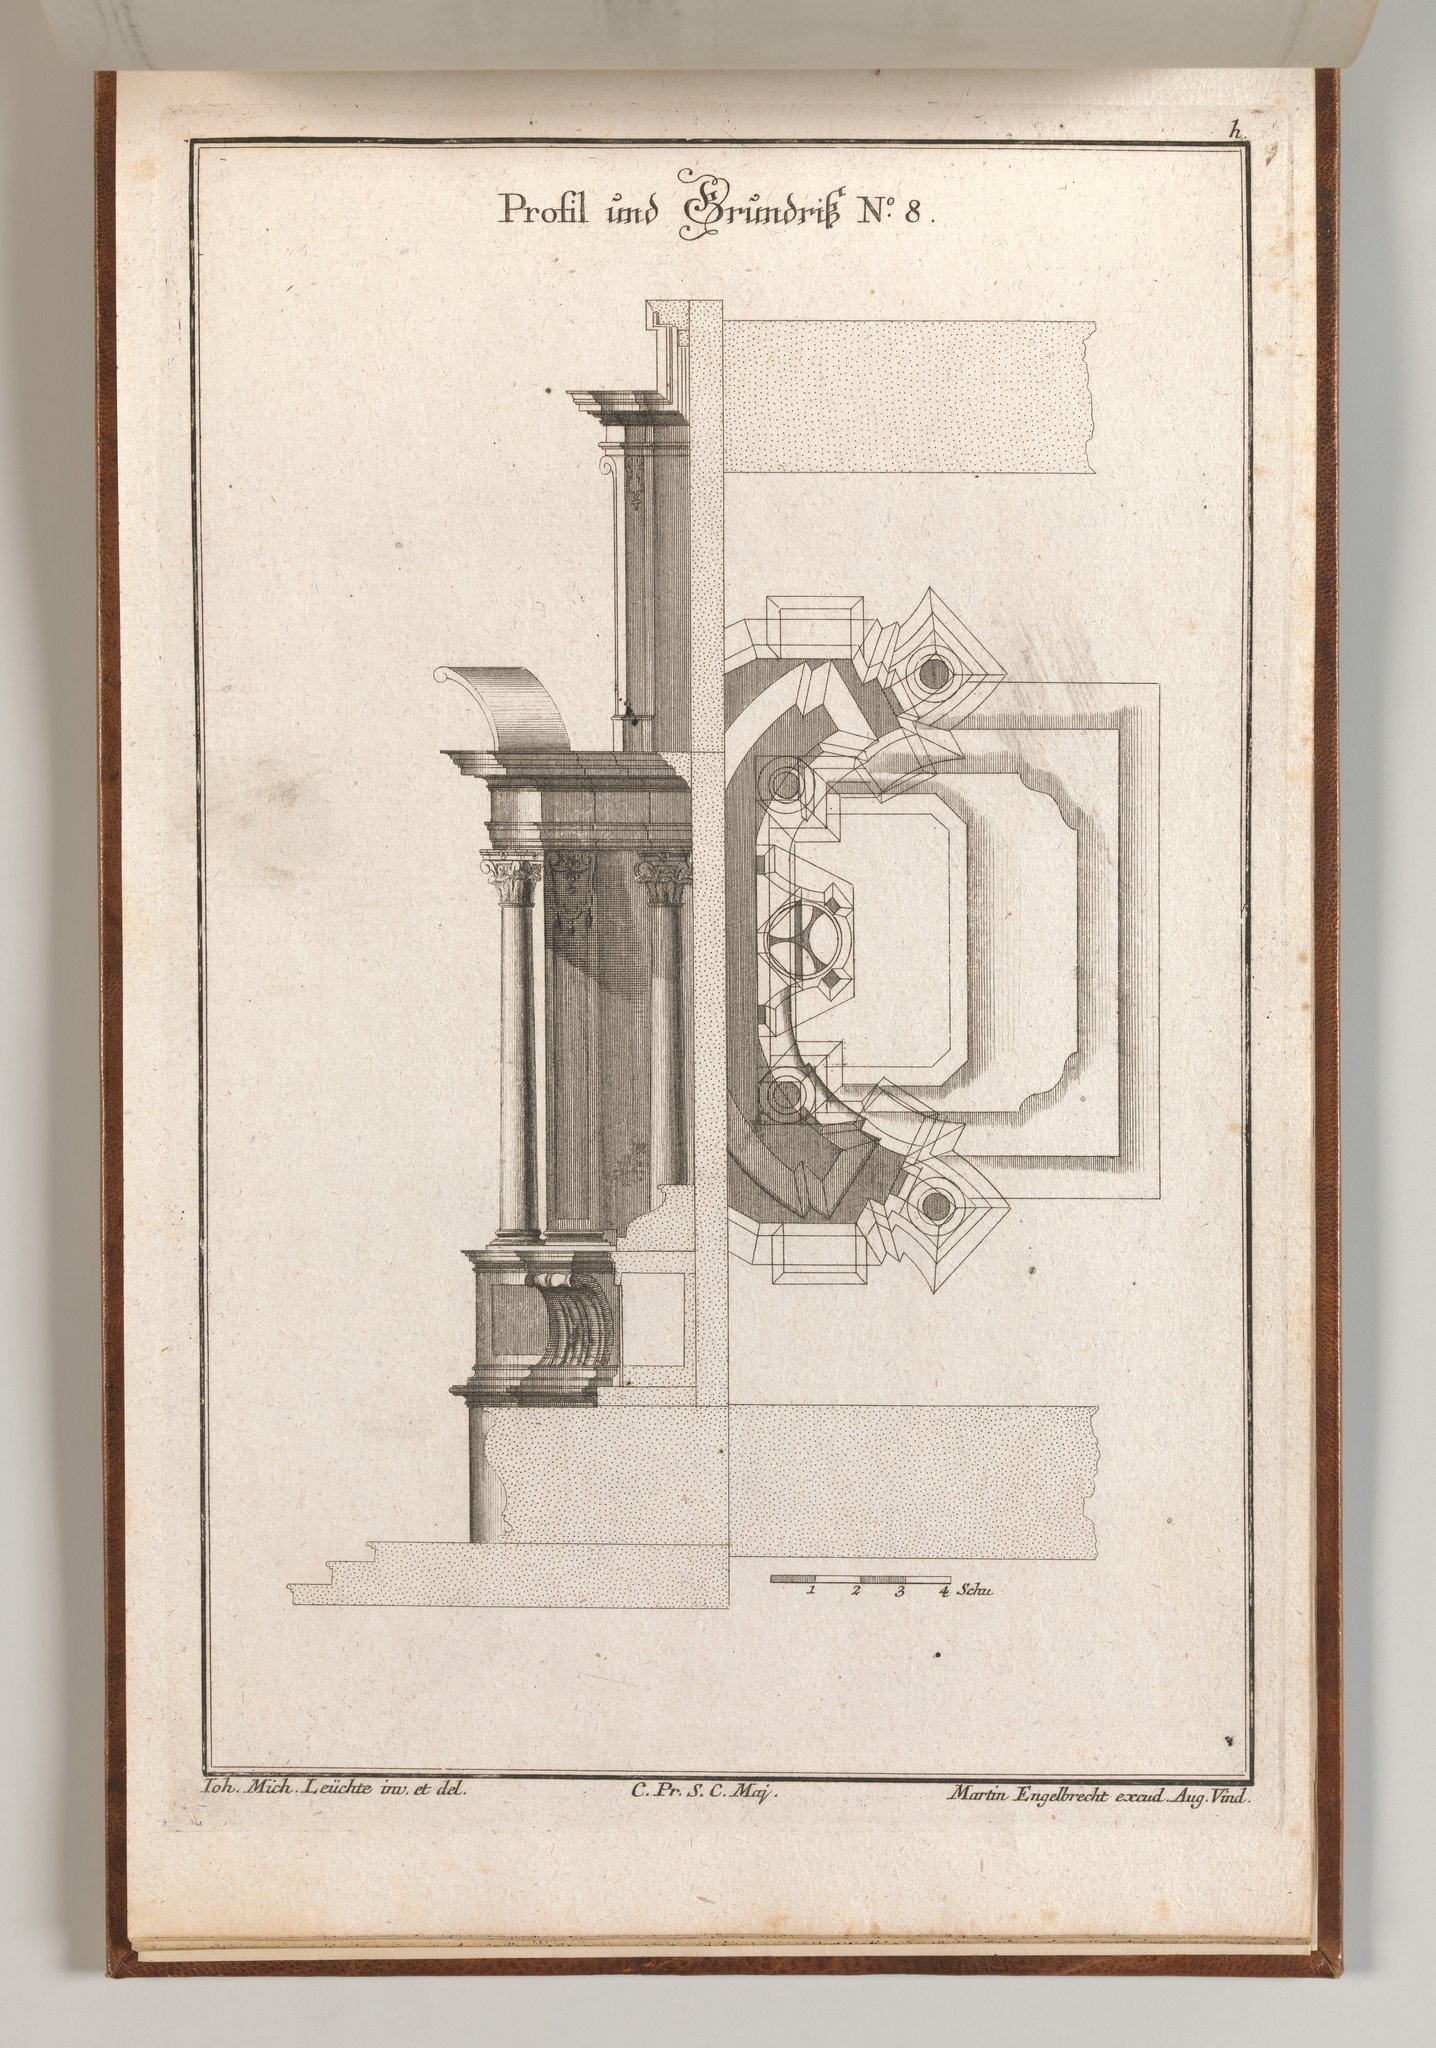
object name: album print ornament architecture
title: Floorplan and Side View of an Altar, Plate h (2) from 'Unterschiedliche Neu Inventierte Altäre mit darzu gehörigen Profillen u. Grundrißen.'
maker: johann michael leüchte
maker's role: artist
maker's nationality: german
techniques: etching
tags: altars